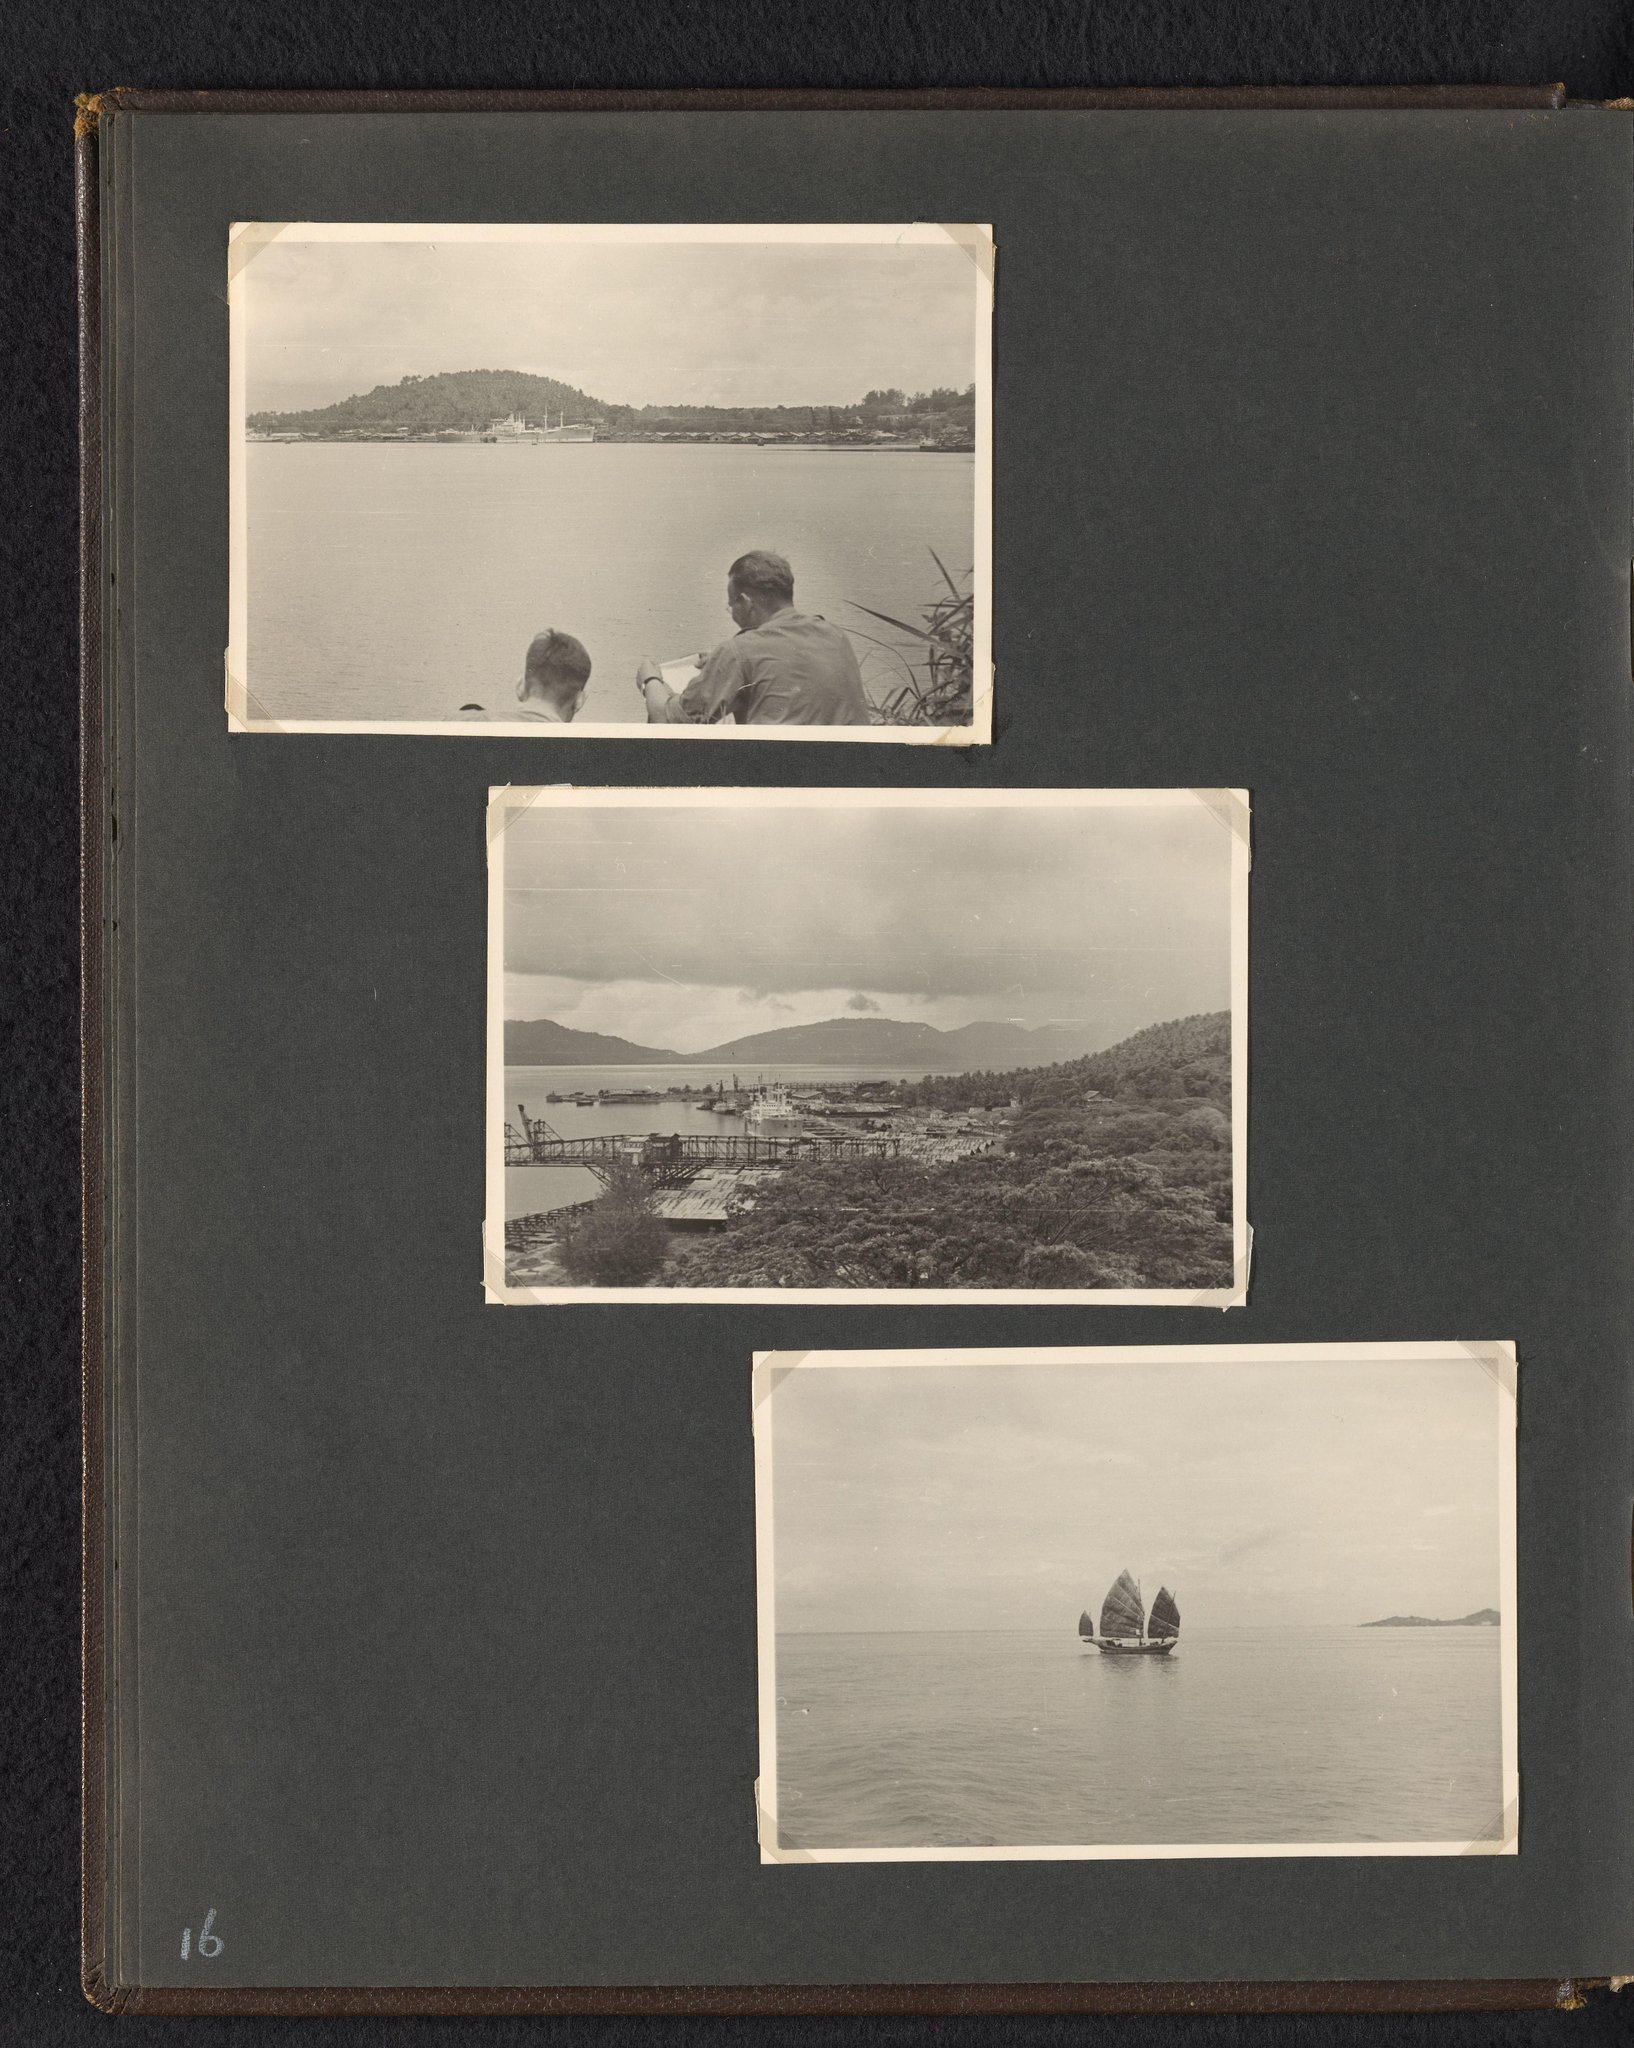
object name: photograph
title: Tussenstop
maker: Anonymous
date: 1947-1948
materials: cardboard, photographic support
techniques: gelatin silver print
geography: asia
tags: troop movements, transportation, the company, the unit, the troop ~ military service, steamship, motorship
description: Albumblad met drie foto's tijdens een tussenstop in Azië van het schip de S.S. Waterman, onderweg naar Nederlands-Indië. Onderdeel van het fotoalbum 'Mijn jaren in Indië' met foto's over de militaire acties in Nederlands-Indië.